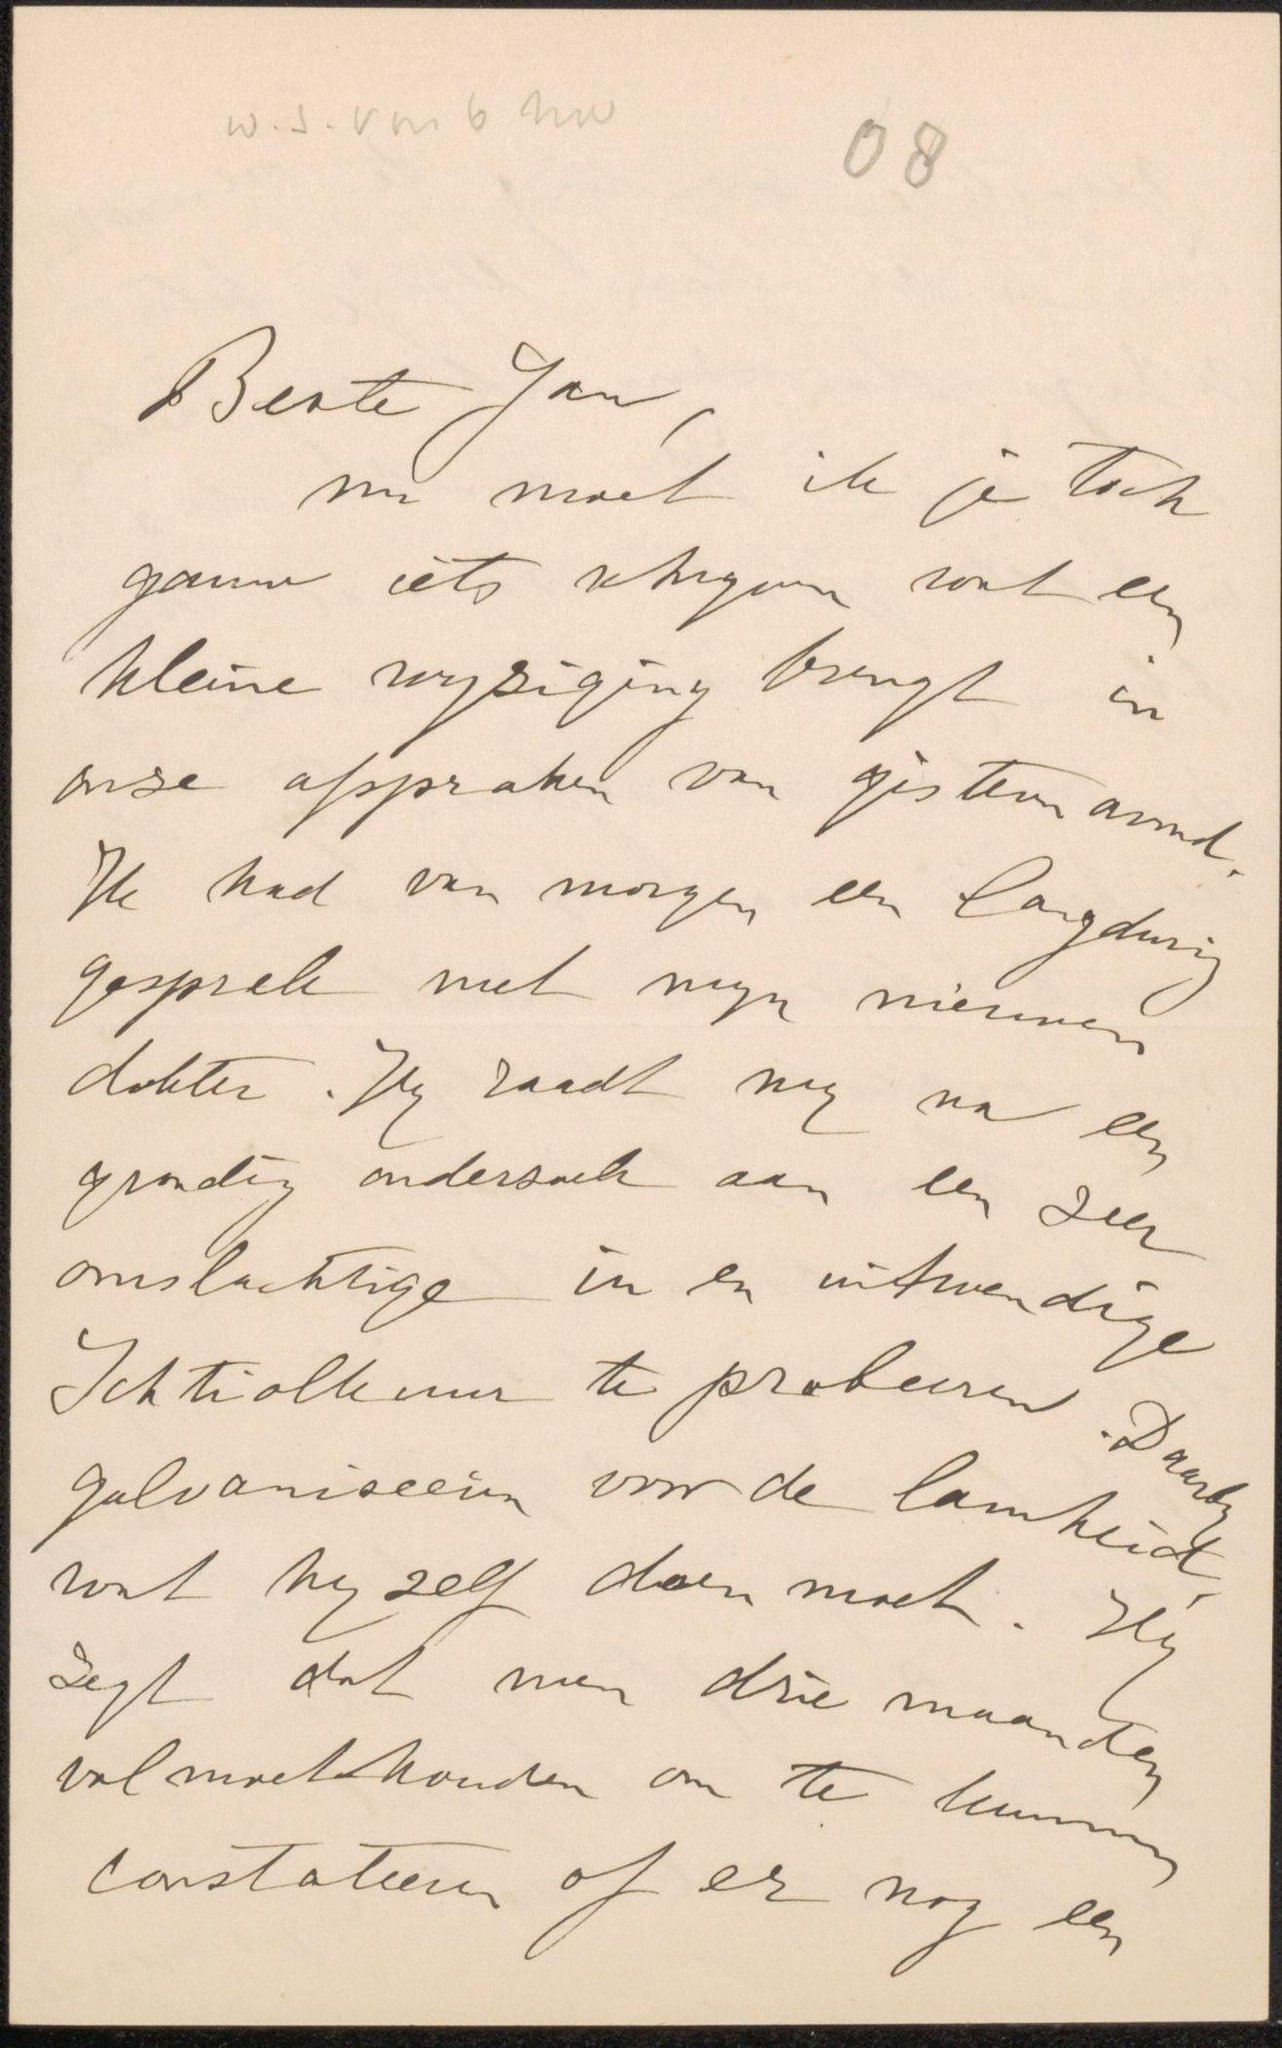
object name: letter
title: Brief aan Jan Veth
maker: wally moes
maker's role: draughtsman, print maker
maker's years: 1856-1918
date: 1874-1918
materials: ink, paper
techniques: pen, writing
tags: dordrecht, painter, designer, jan veth, workshop, studio of the artist (in general), diseases, berlin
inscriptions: collector's mark: ‘RPK’